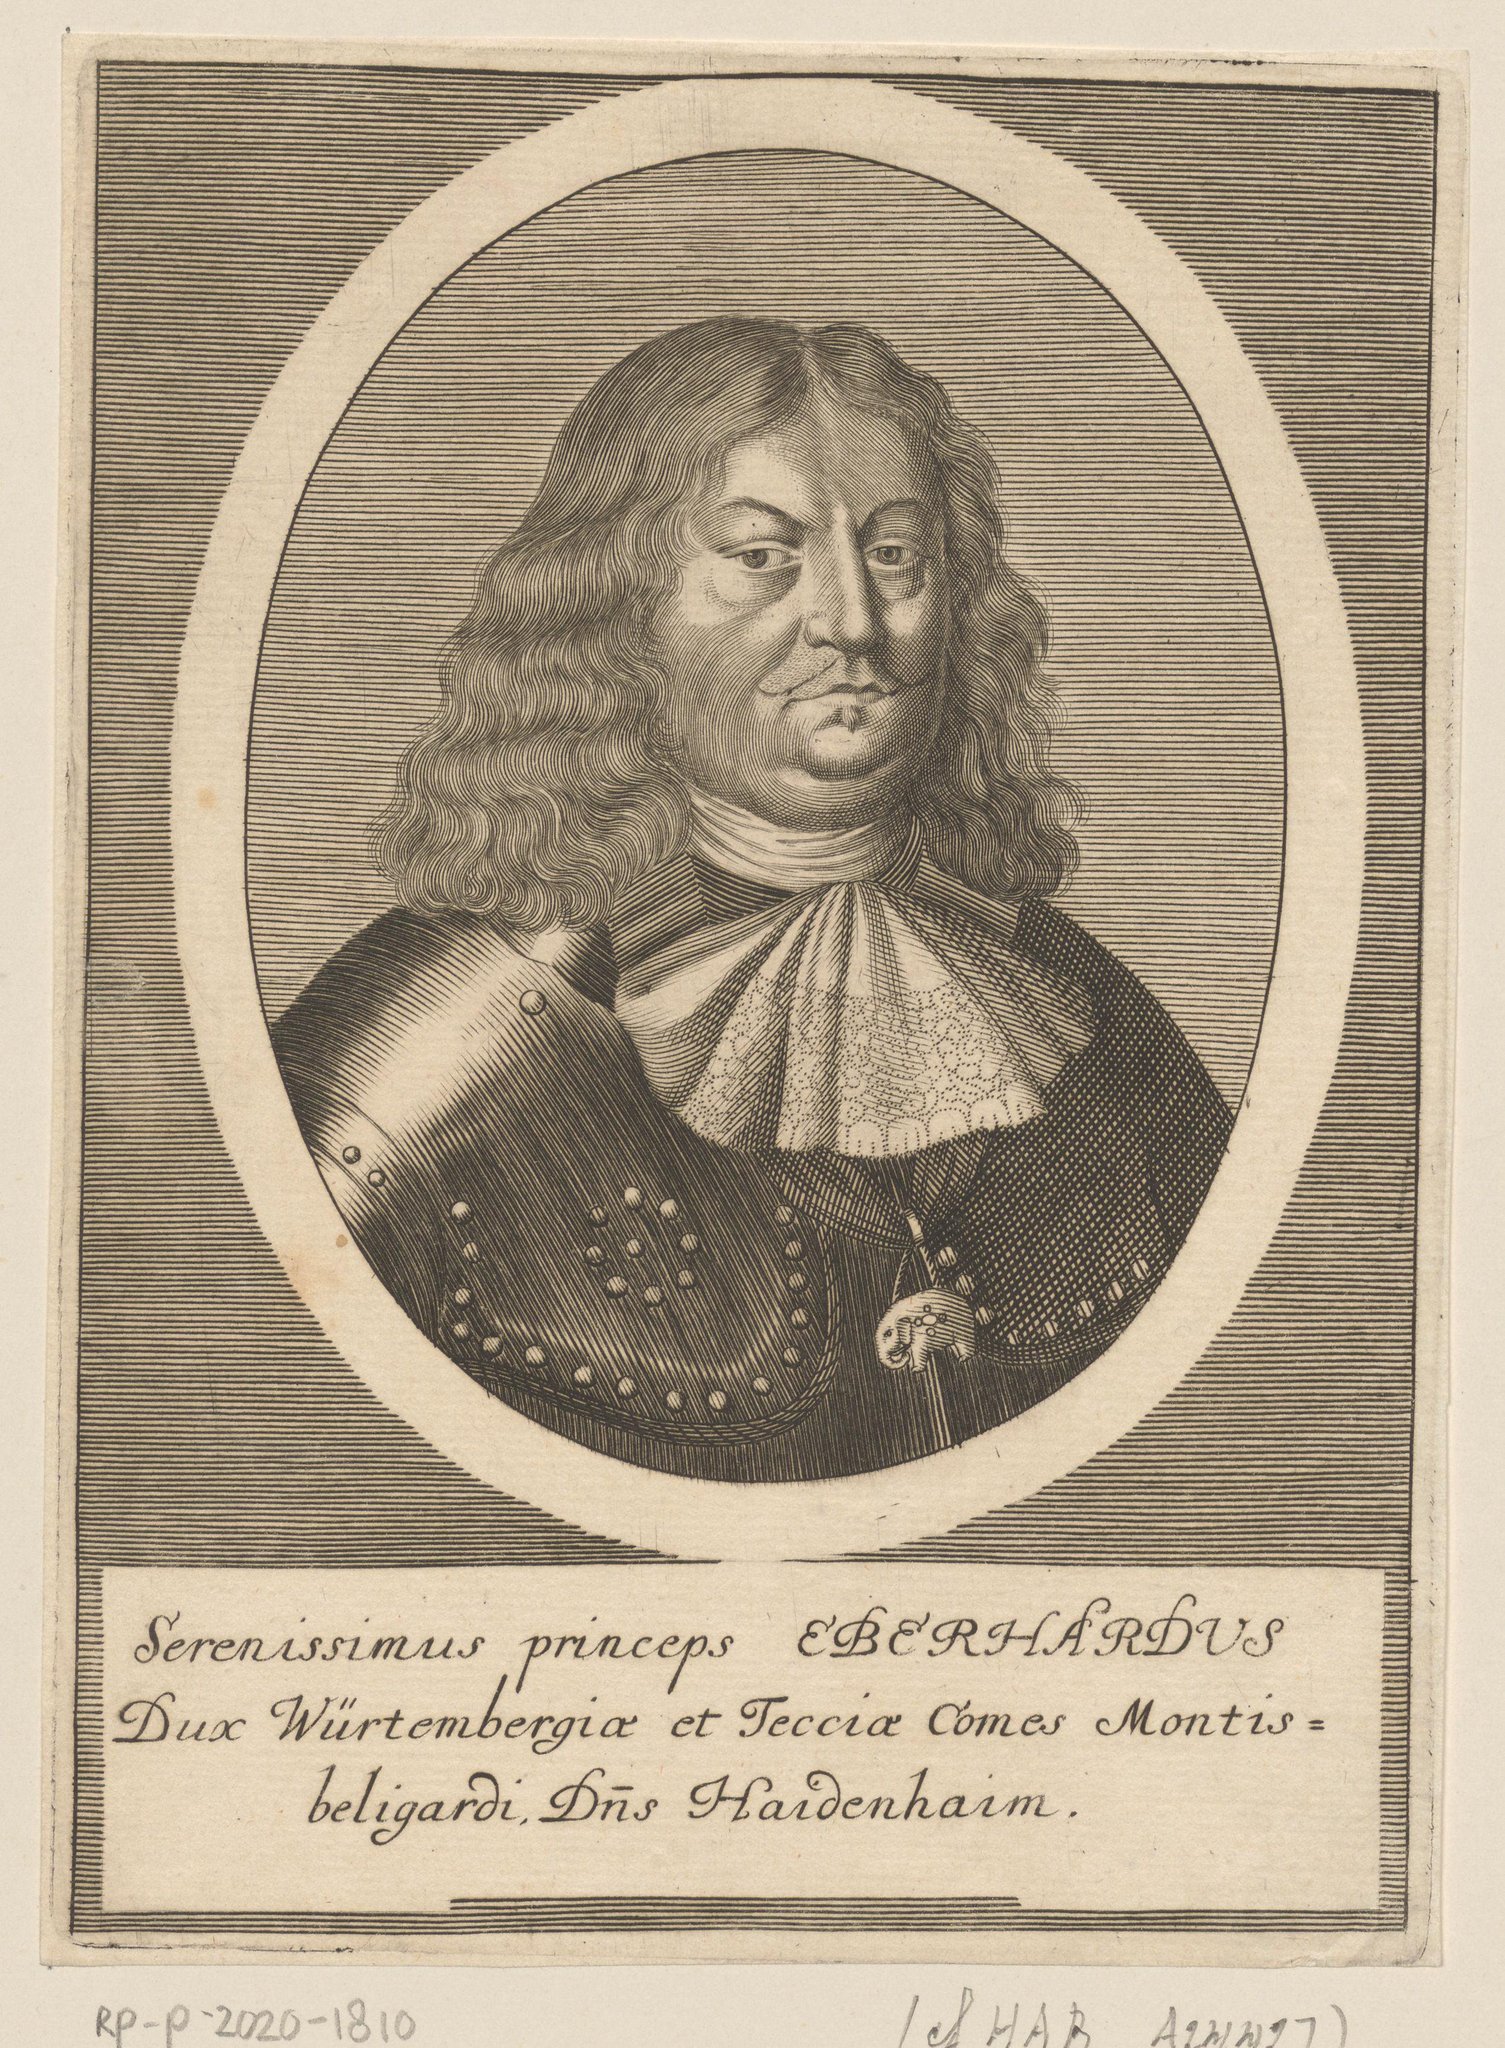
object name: print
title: Portret van Eberhard III von Württemberg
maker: Anonymous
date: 1660-1700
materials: paper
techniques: engraving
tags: eberhard von württemberg (iii), historical persons